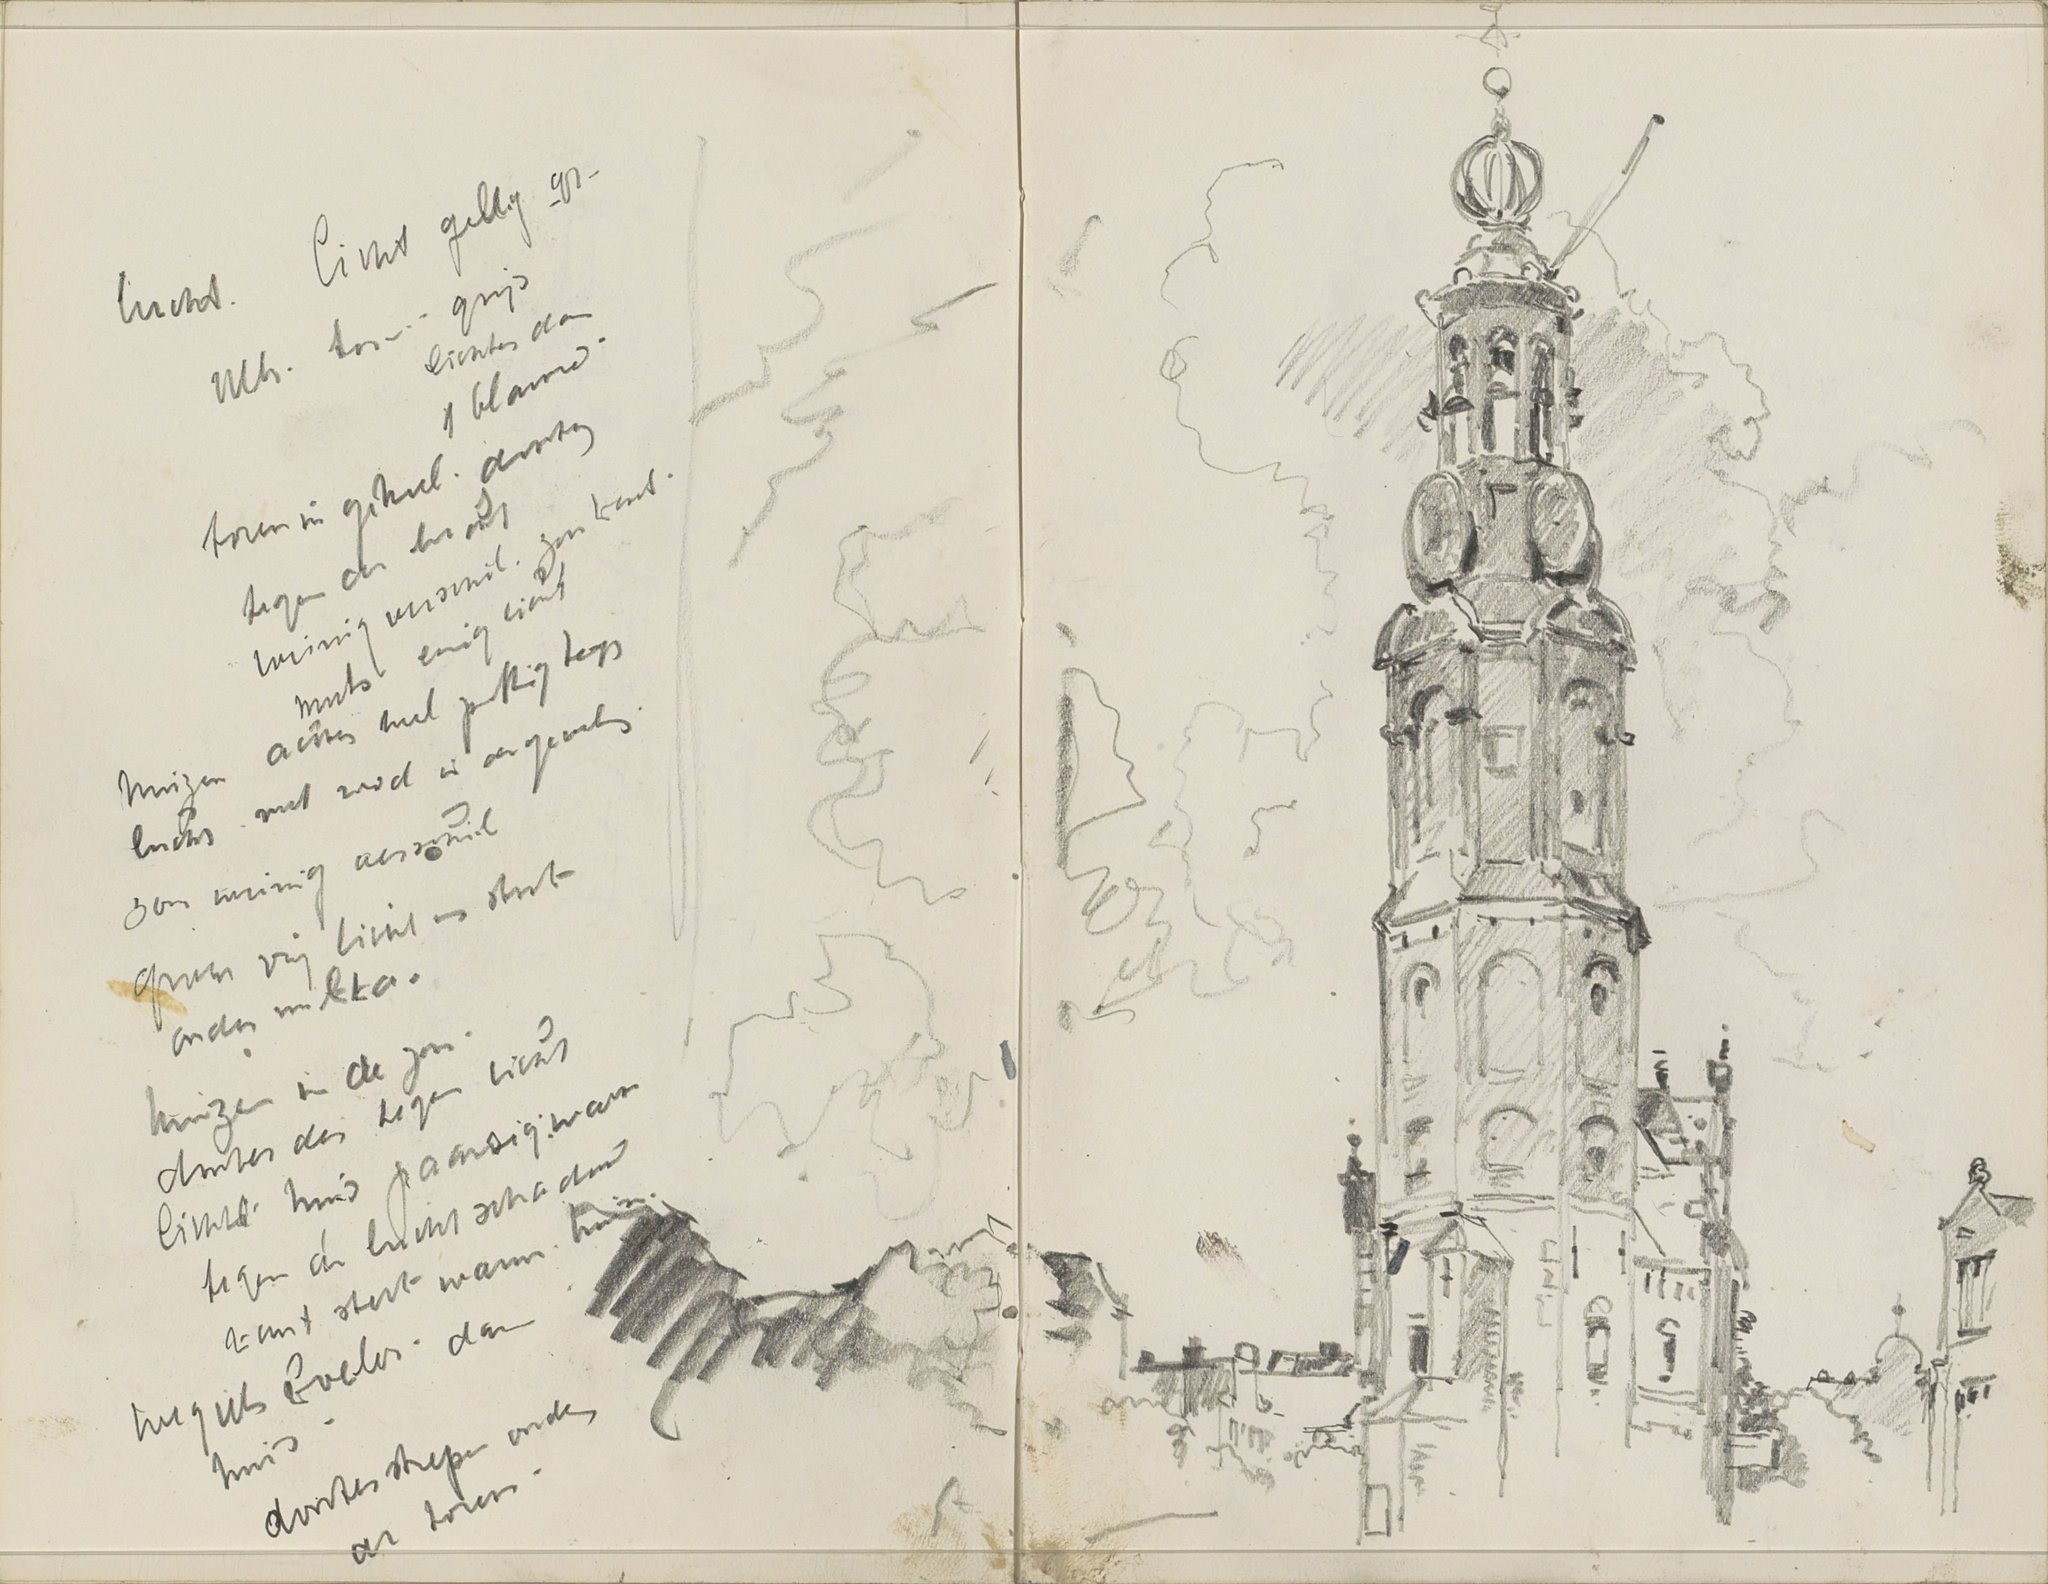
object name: sketchbook leaf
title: Munttoren te Amsterdam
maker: cornelis vreedenburgh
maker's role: draughtsman, print maker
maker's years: 1880-1946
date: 1890-1946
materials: paper, pencil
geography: amsterdam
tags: tower (of house or building)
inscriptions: kleurnotitie, handgeschreven in potlood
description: Blad 26 verso en 27 recto uit een schetsboek met 41 bladen.